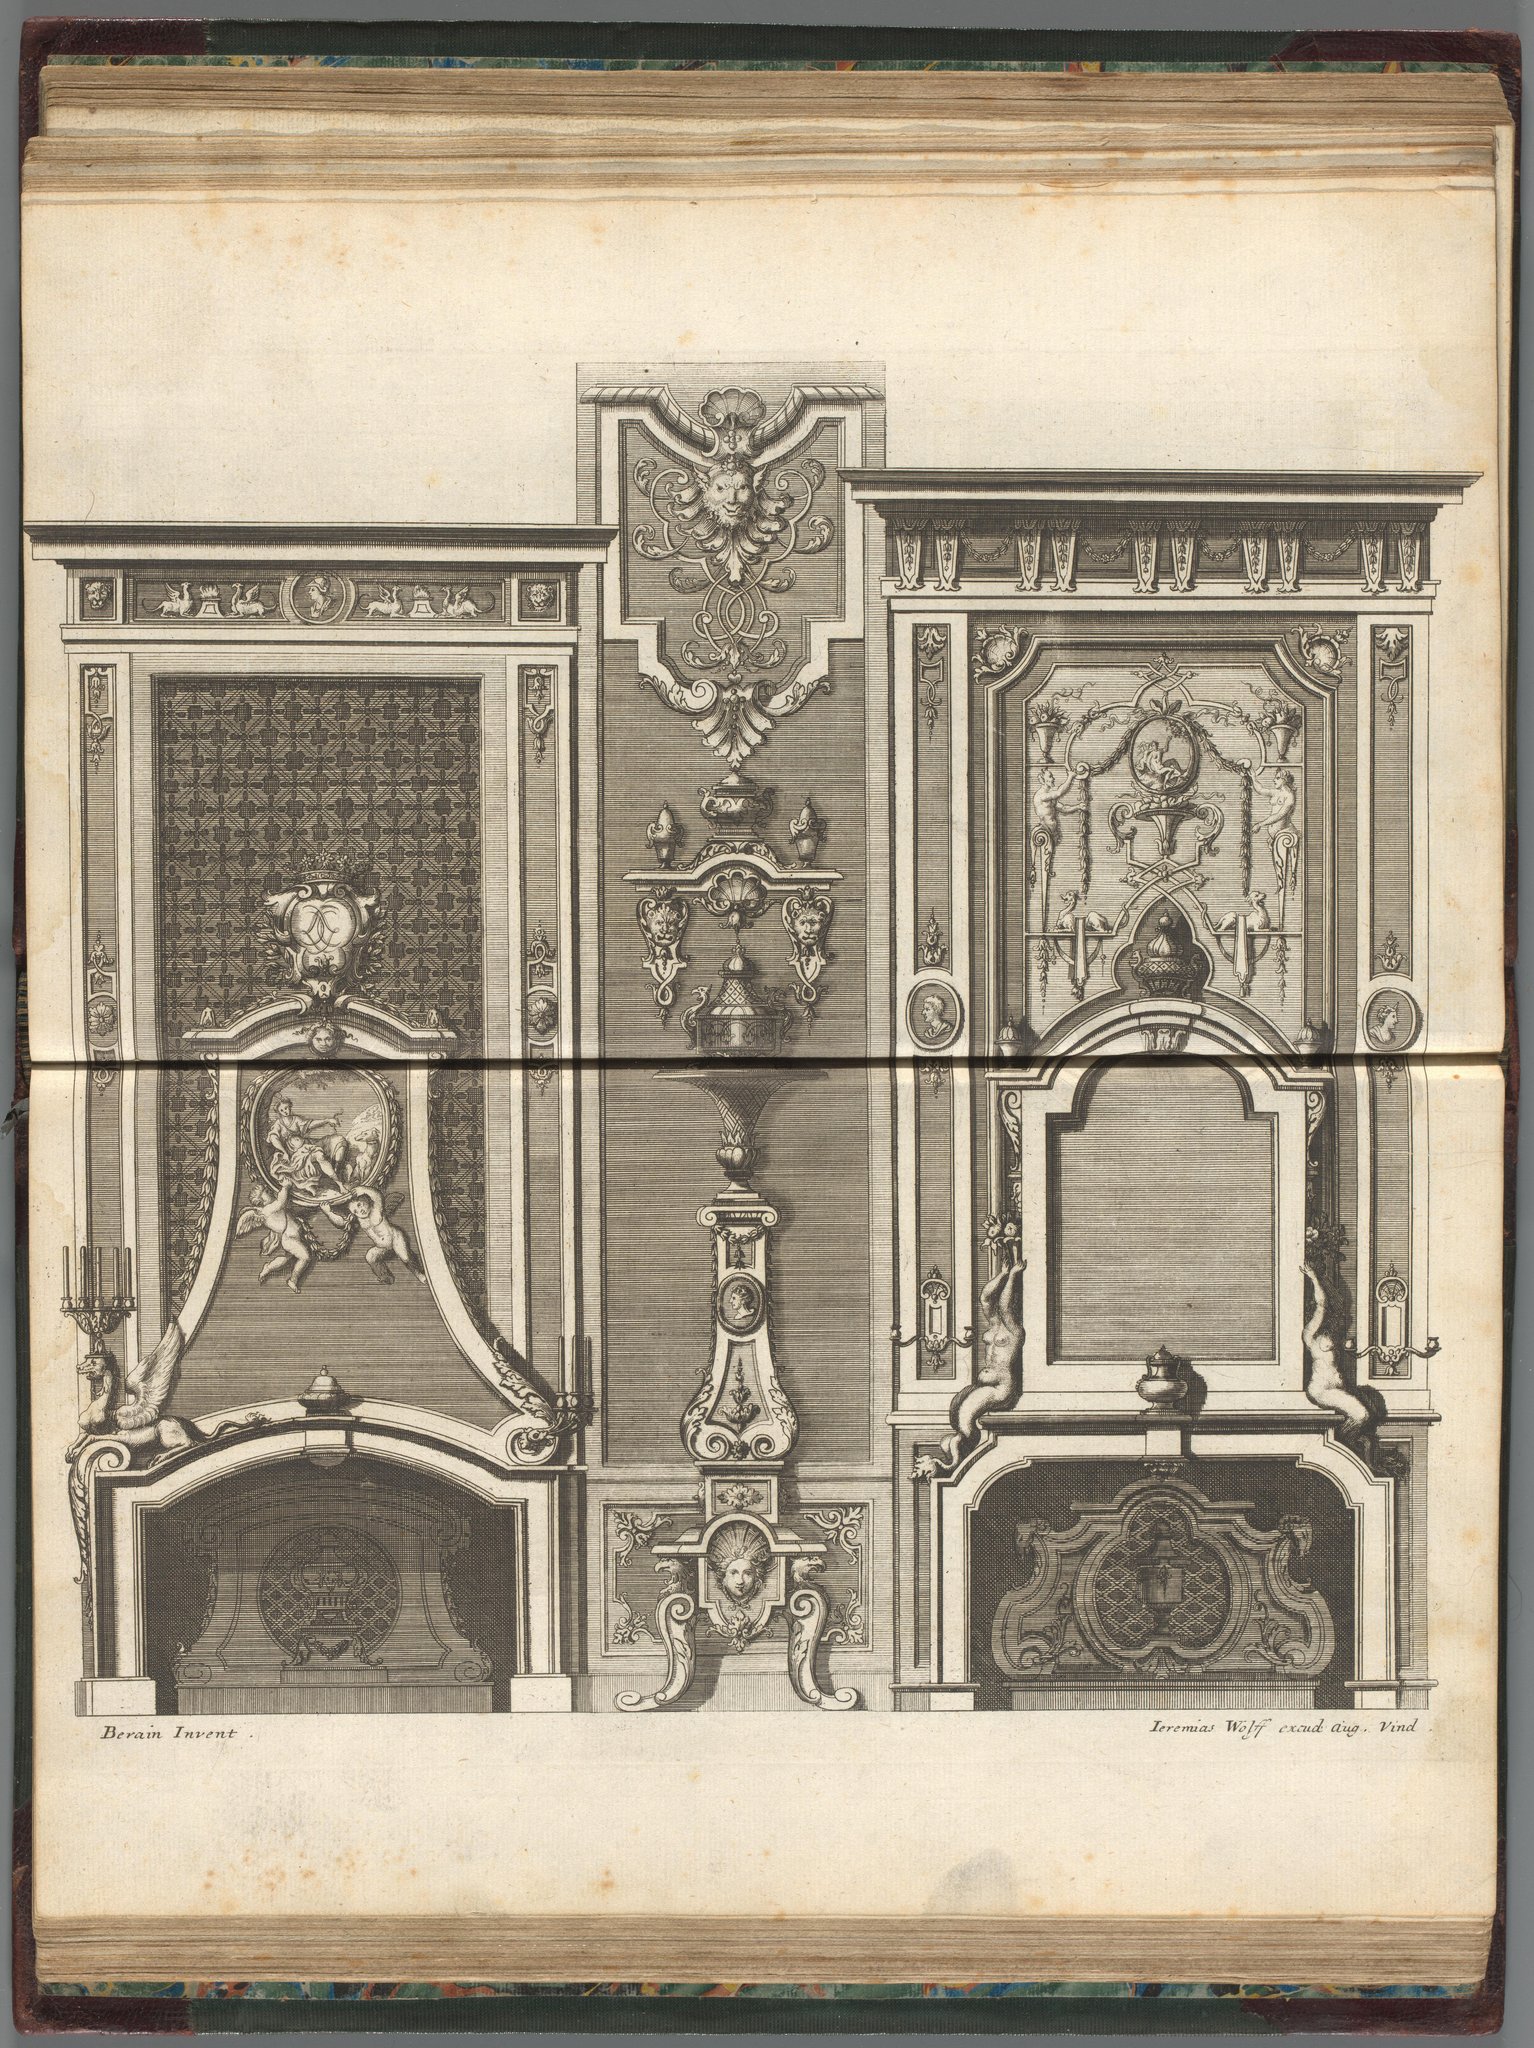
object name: print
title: Haarden met medaillons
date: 1686-1724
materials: paper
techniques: etching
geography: augsburg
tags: ornaments ~ art, fire-screen, triton(s), open hearth, fire-place, cupids: 'amores', 'amoretti', 'putti'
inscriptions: signature: ‘Ieremias Wolff excud. Aug. Vind.’, signature: ‘Berain Invent’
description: Twee geornamenteerde haarden. Links met een medaillon met daarin een vrouw met boog en een hond, aan het medaillon hangen twee putti, links een griffioen met kandelaar op het hoofd en onderaan een haardplaat met rookvat. Rechts met een medaillon met twee figuren geflankeerd door een atlant en een kariatide, in het midden twee medaillons met portretten en het geheel gedragen door twee tritons. Onderaan een haardplaat met ramskoppen. De haarden flankeren een paneel met maskers. Prent maakt deel uit van een album. Hoogstwaarschijnlijk gespiegelde kopie naar Frans origineel.